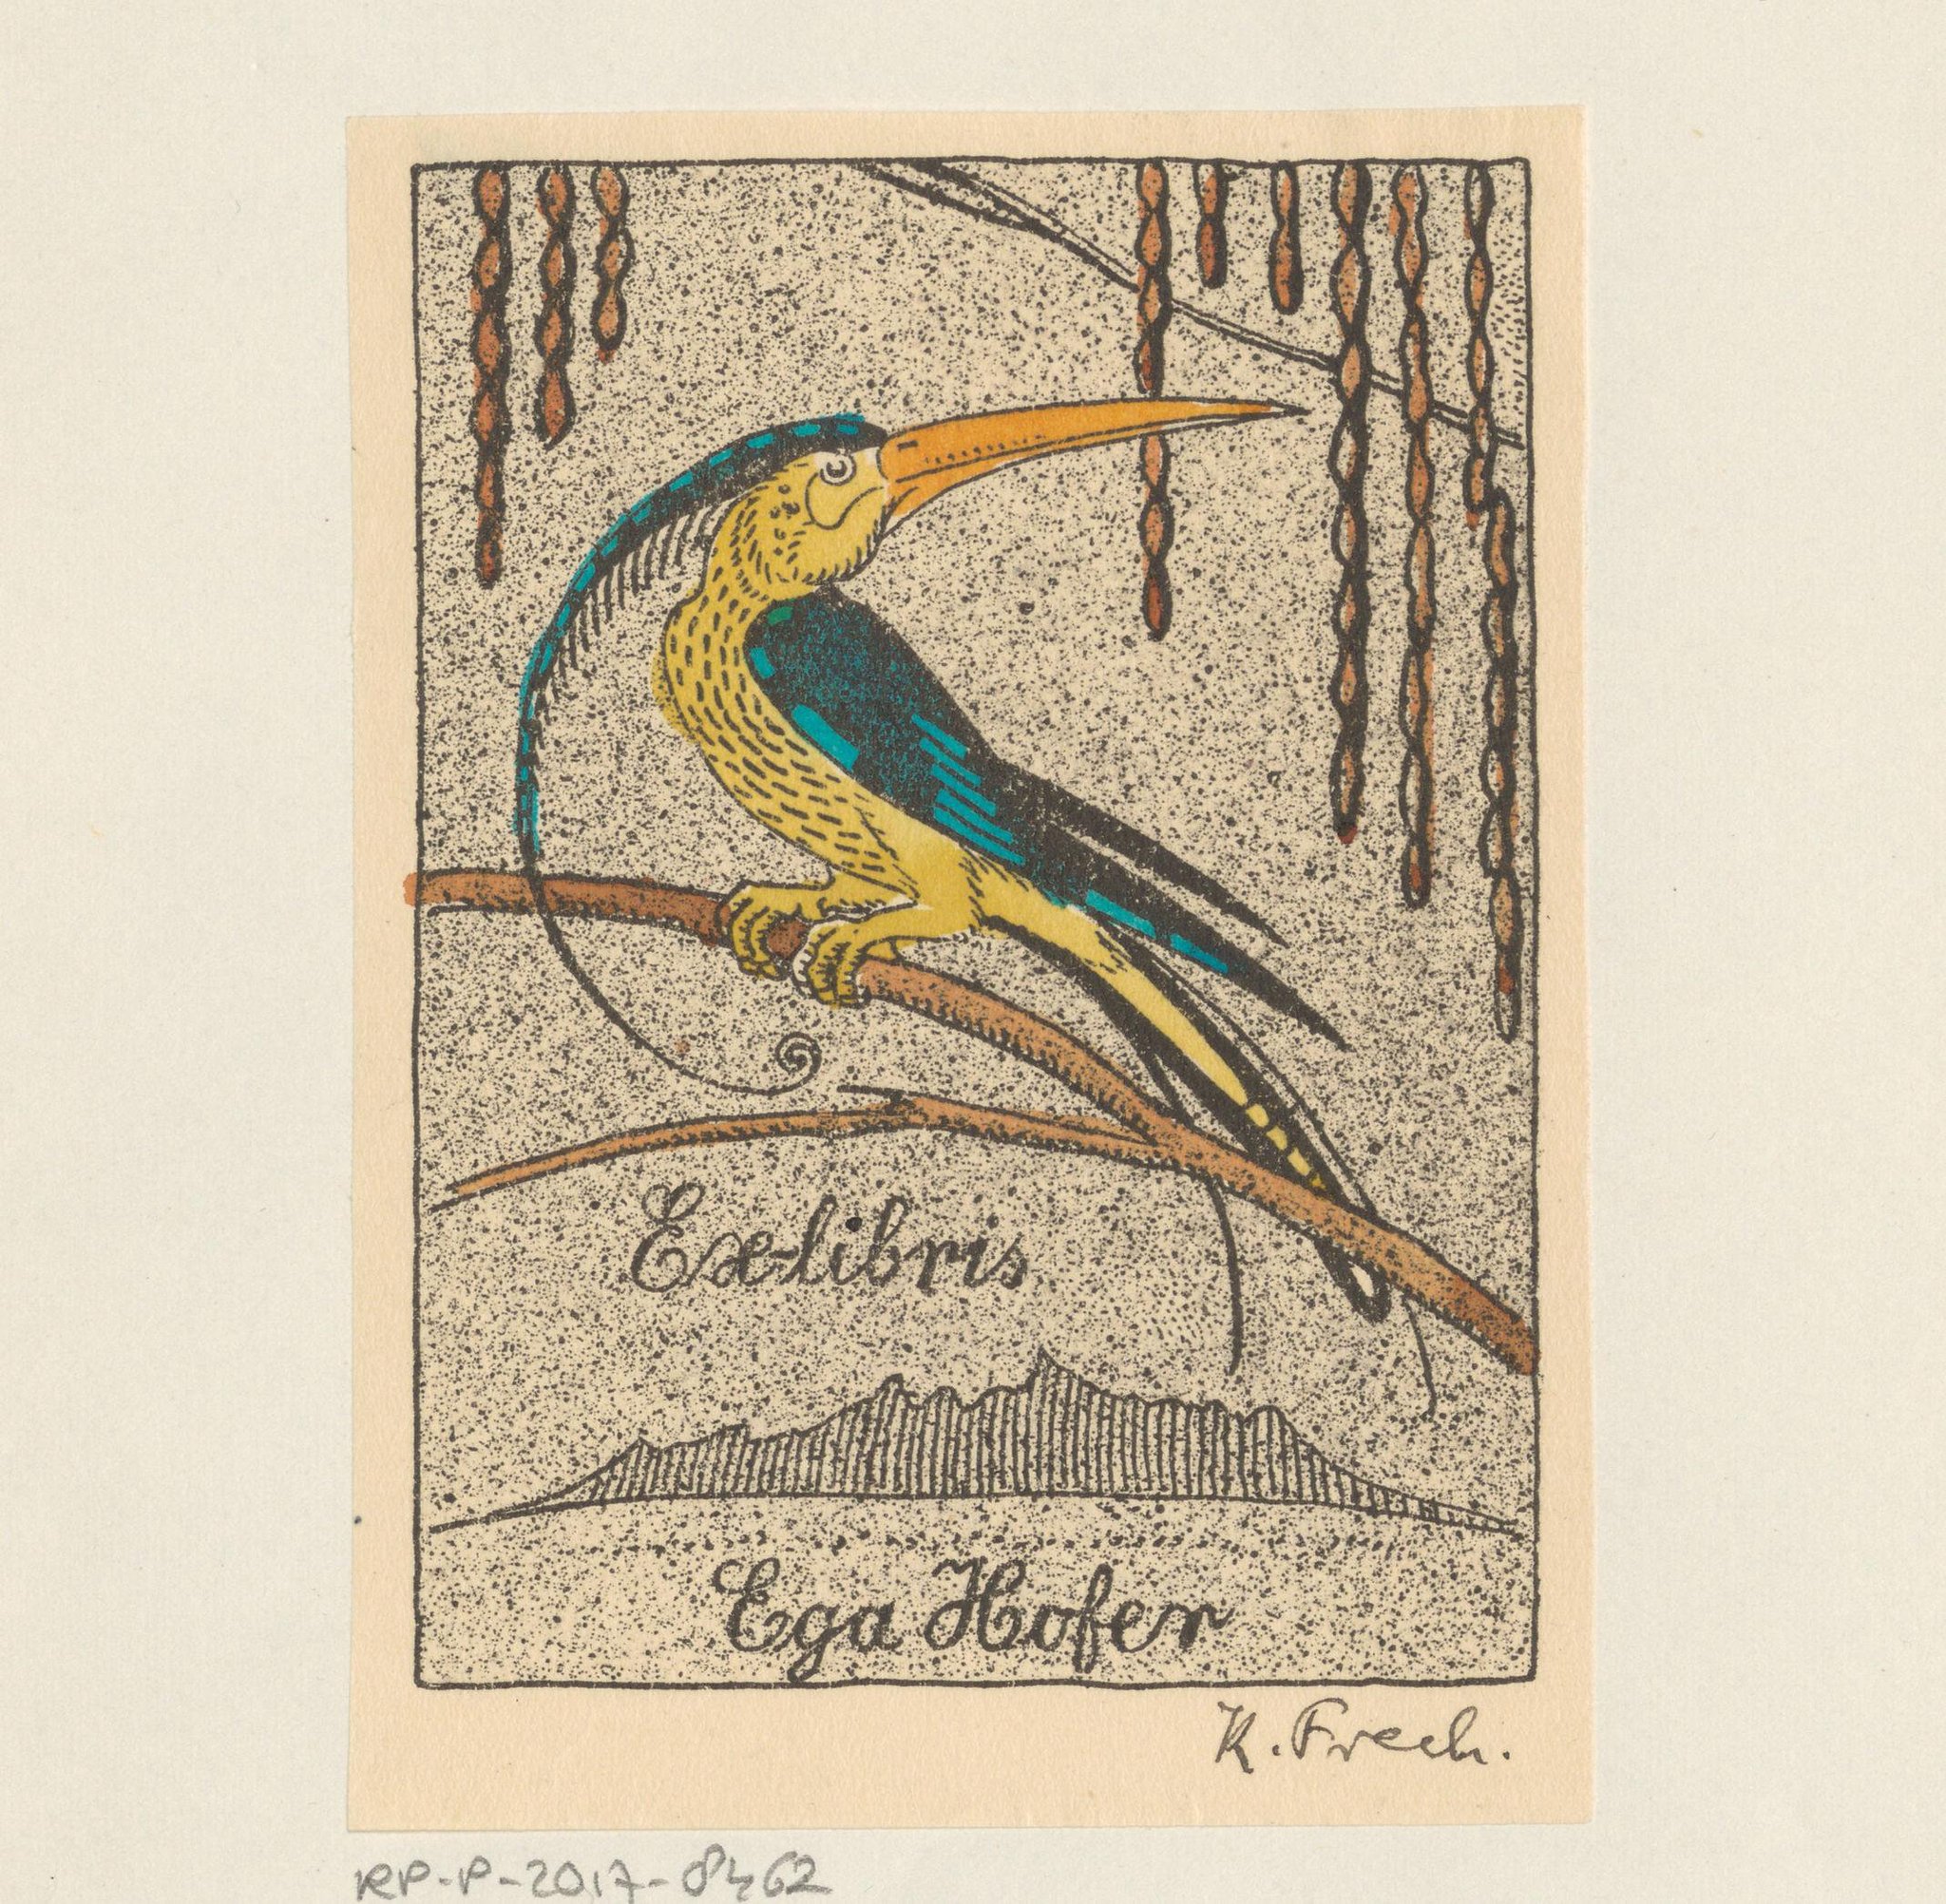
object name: bookplate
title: Ex libris van Ega Hofer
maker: karl hugo frech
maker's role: print maker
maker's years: 1883-1945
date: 1893-1945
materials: paper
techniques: hand coloring, lithograph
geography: bratislava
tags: birds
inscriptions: signature: ‘K. Frech’, workshop stamp: ‘Karl Frech/ Maler-Graphiker/ Bratislava - Pressburg/ Simonyi Ivan Rad. 6.’